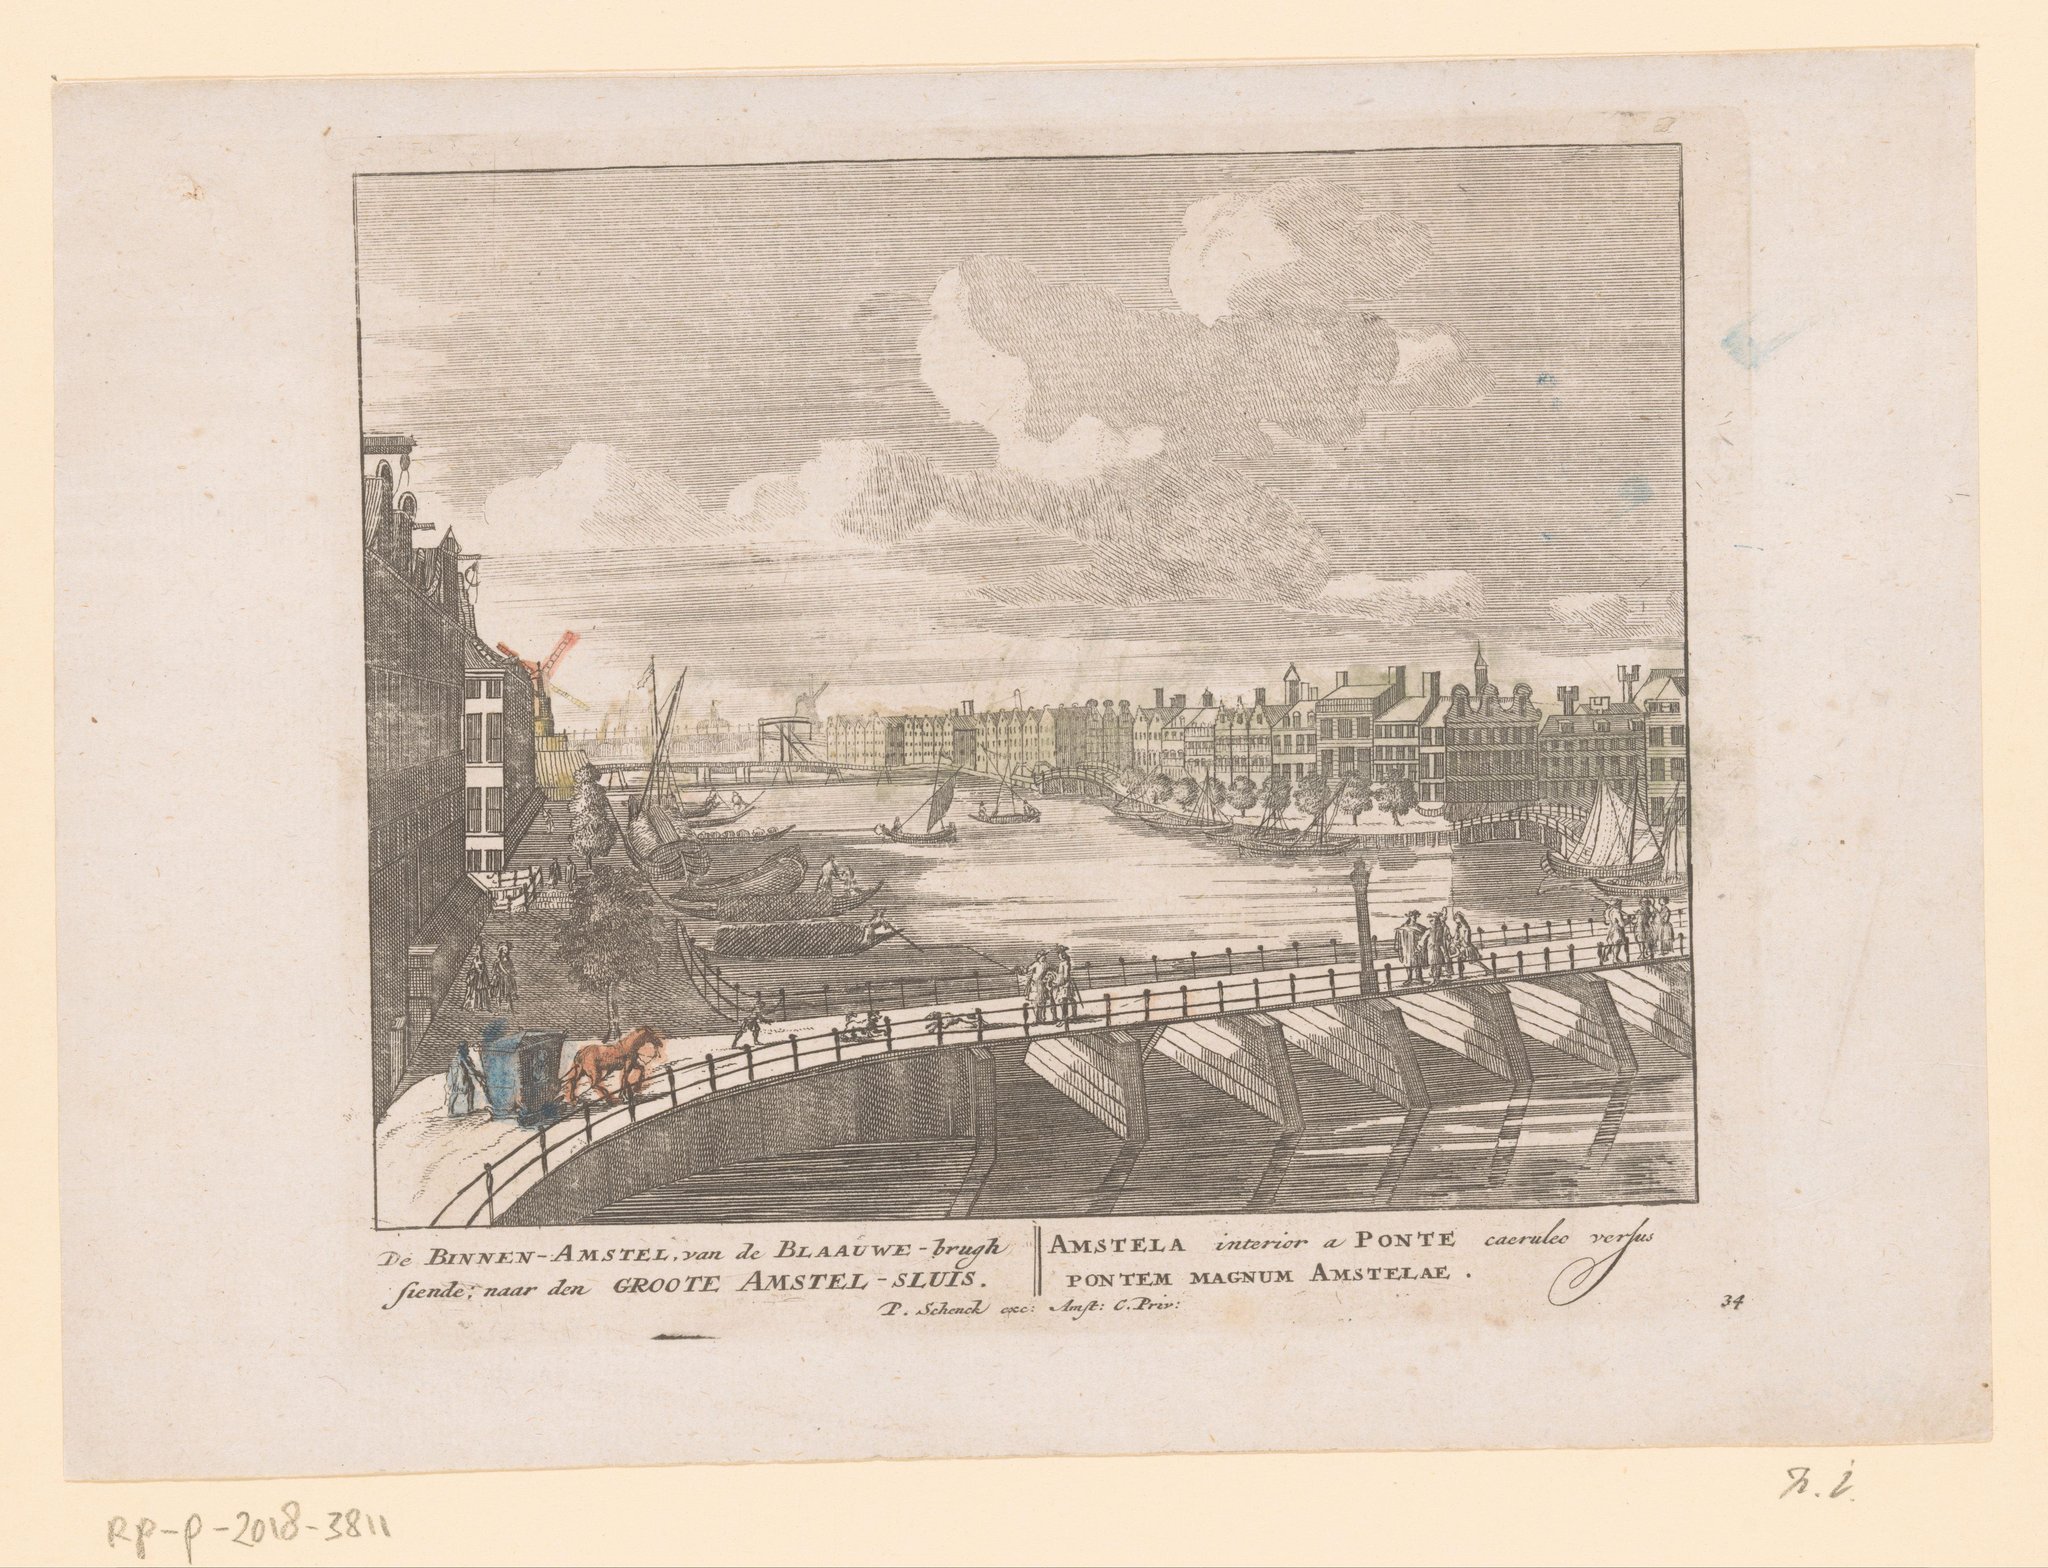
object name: print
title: De Binnen-Amstel van de Blaauwe-brugh ziende, naar den Groote Amstel-Sluis / Amstela interior a Ponte caeruleo versus pontem magnum Amstelae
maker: Anonymous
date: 1710-1711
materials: paper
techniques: etching, hand coloring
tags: city-view, and landscape with man-made constructions, canals, waters (in city), bridge in city across river, canal, etc.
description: Huidige staat van prent ook gebruikt in: 100 Afbeeldinge der voornaamste gebouwen van Amsterdam. Amsterdam: Pieter Schenk (I), s.a. [1710-1711]. En in: 100 Afbeeldinge der voornaamste gebouwen van Amsterdam. Amsterdam: Barent Greve, s.a. [1757-1766].* *In de tweede uitgave, uitgegeven door Barent Greve, is alleen de titelprent aangepast. De overige prenten zijn onveranderd gebleven.